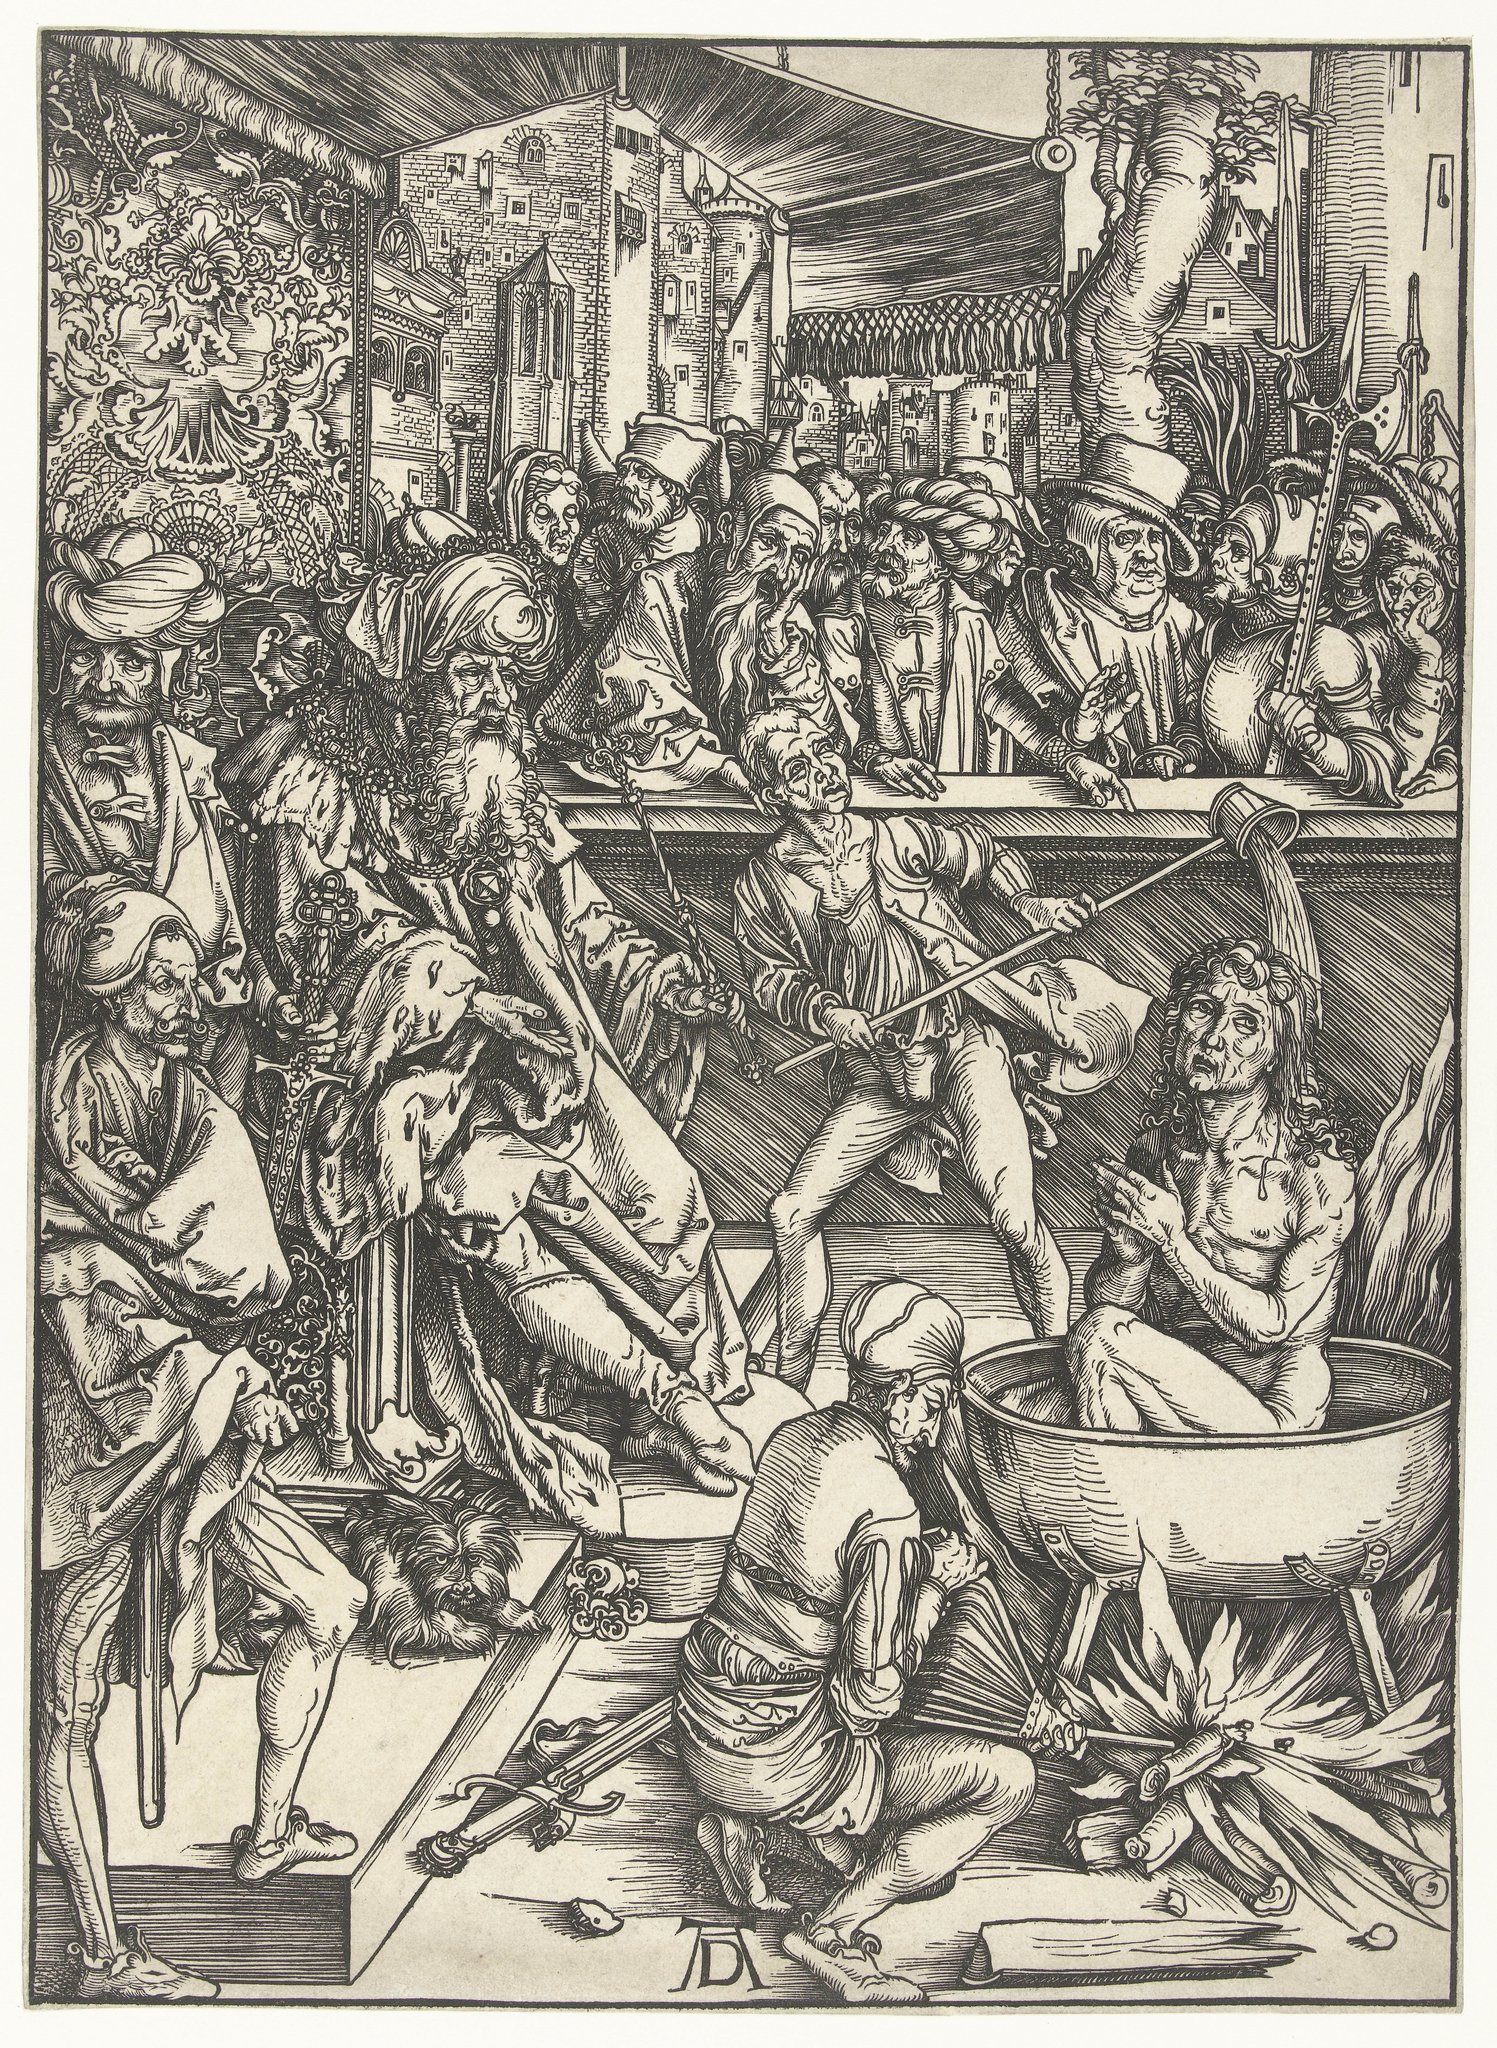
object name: print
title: Het martelaarschap van Johannes de Evangelist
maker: albrecht dürer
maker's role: draughtsman, painter, print maker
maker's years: 1471-1528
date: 1496-1497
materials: paper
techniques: woodcut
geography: nuremberg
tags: martyrdom of john in front of the porta latina: he is put in a cauldron of boiling oil, but remains unharmed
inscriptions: collector's mark: Lugt 2228, collector's mark: Lugt 2760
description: Voor een man op een troon zit Johannes de Evangelist met de handen gevouwen in een ketel die op een vuur staat. Een man houdt met een blaasbalg het vuur hoog, een andere man giet met een grote lepel kokende olie over Johannes. Vele omstanders kijken toe.